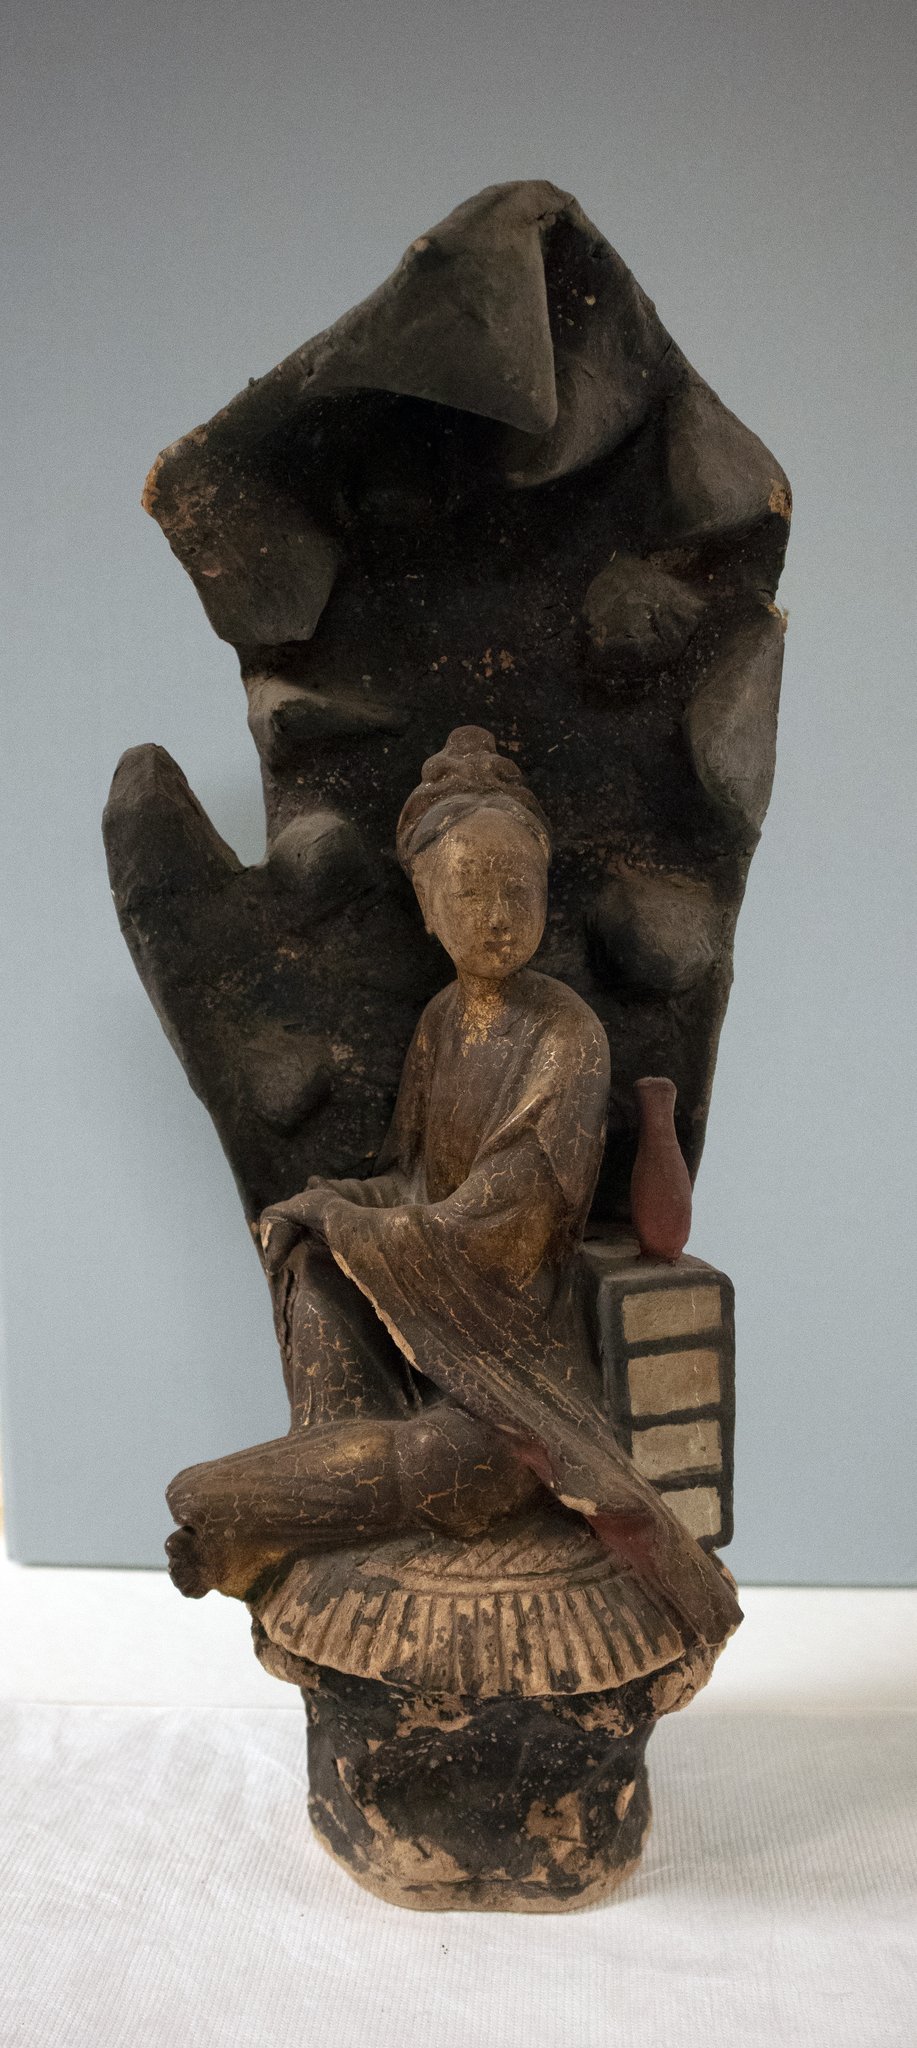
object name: relief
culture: chinese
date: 1701-1800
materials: mud, paper